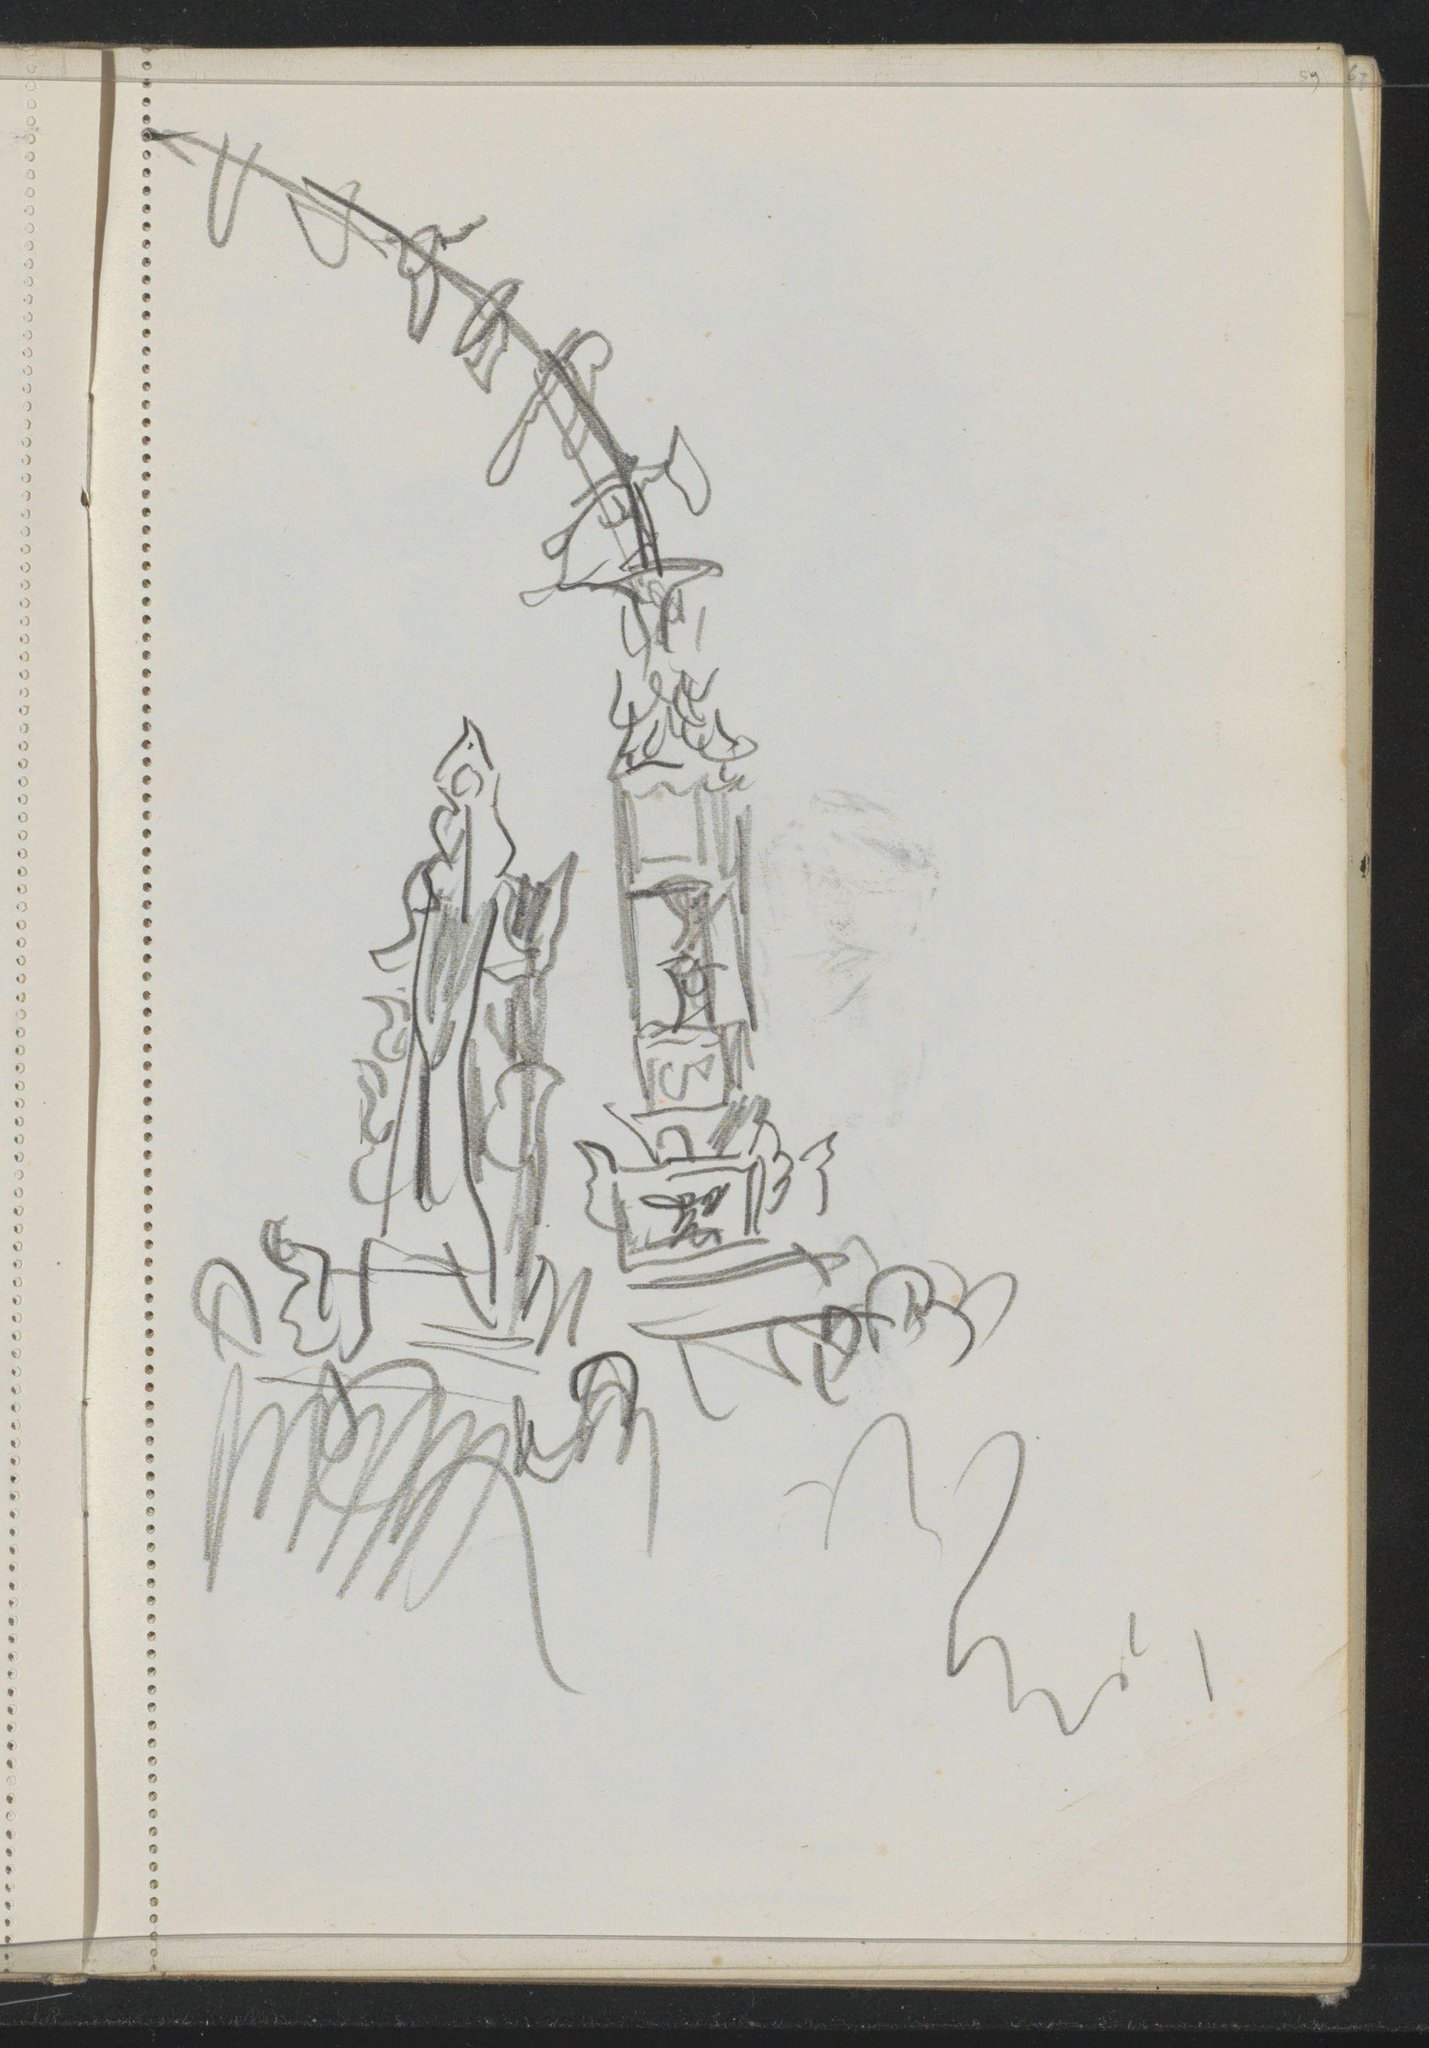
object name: sketchbook leaf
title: Versierde toren en boog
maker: marius bauer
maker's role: draughtsman, print maker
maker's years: 1867-1932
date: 1925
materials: paper, pencil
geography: indonesia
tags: arch, archivolt ~ architecture, architecture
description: Mogelijk decoratiestukken in een optocht of onderdelen van een crematieprocessie. Pagina 59 uit een schetsboek met 74 bladen.